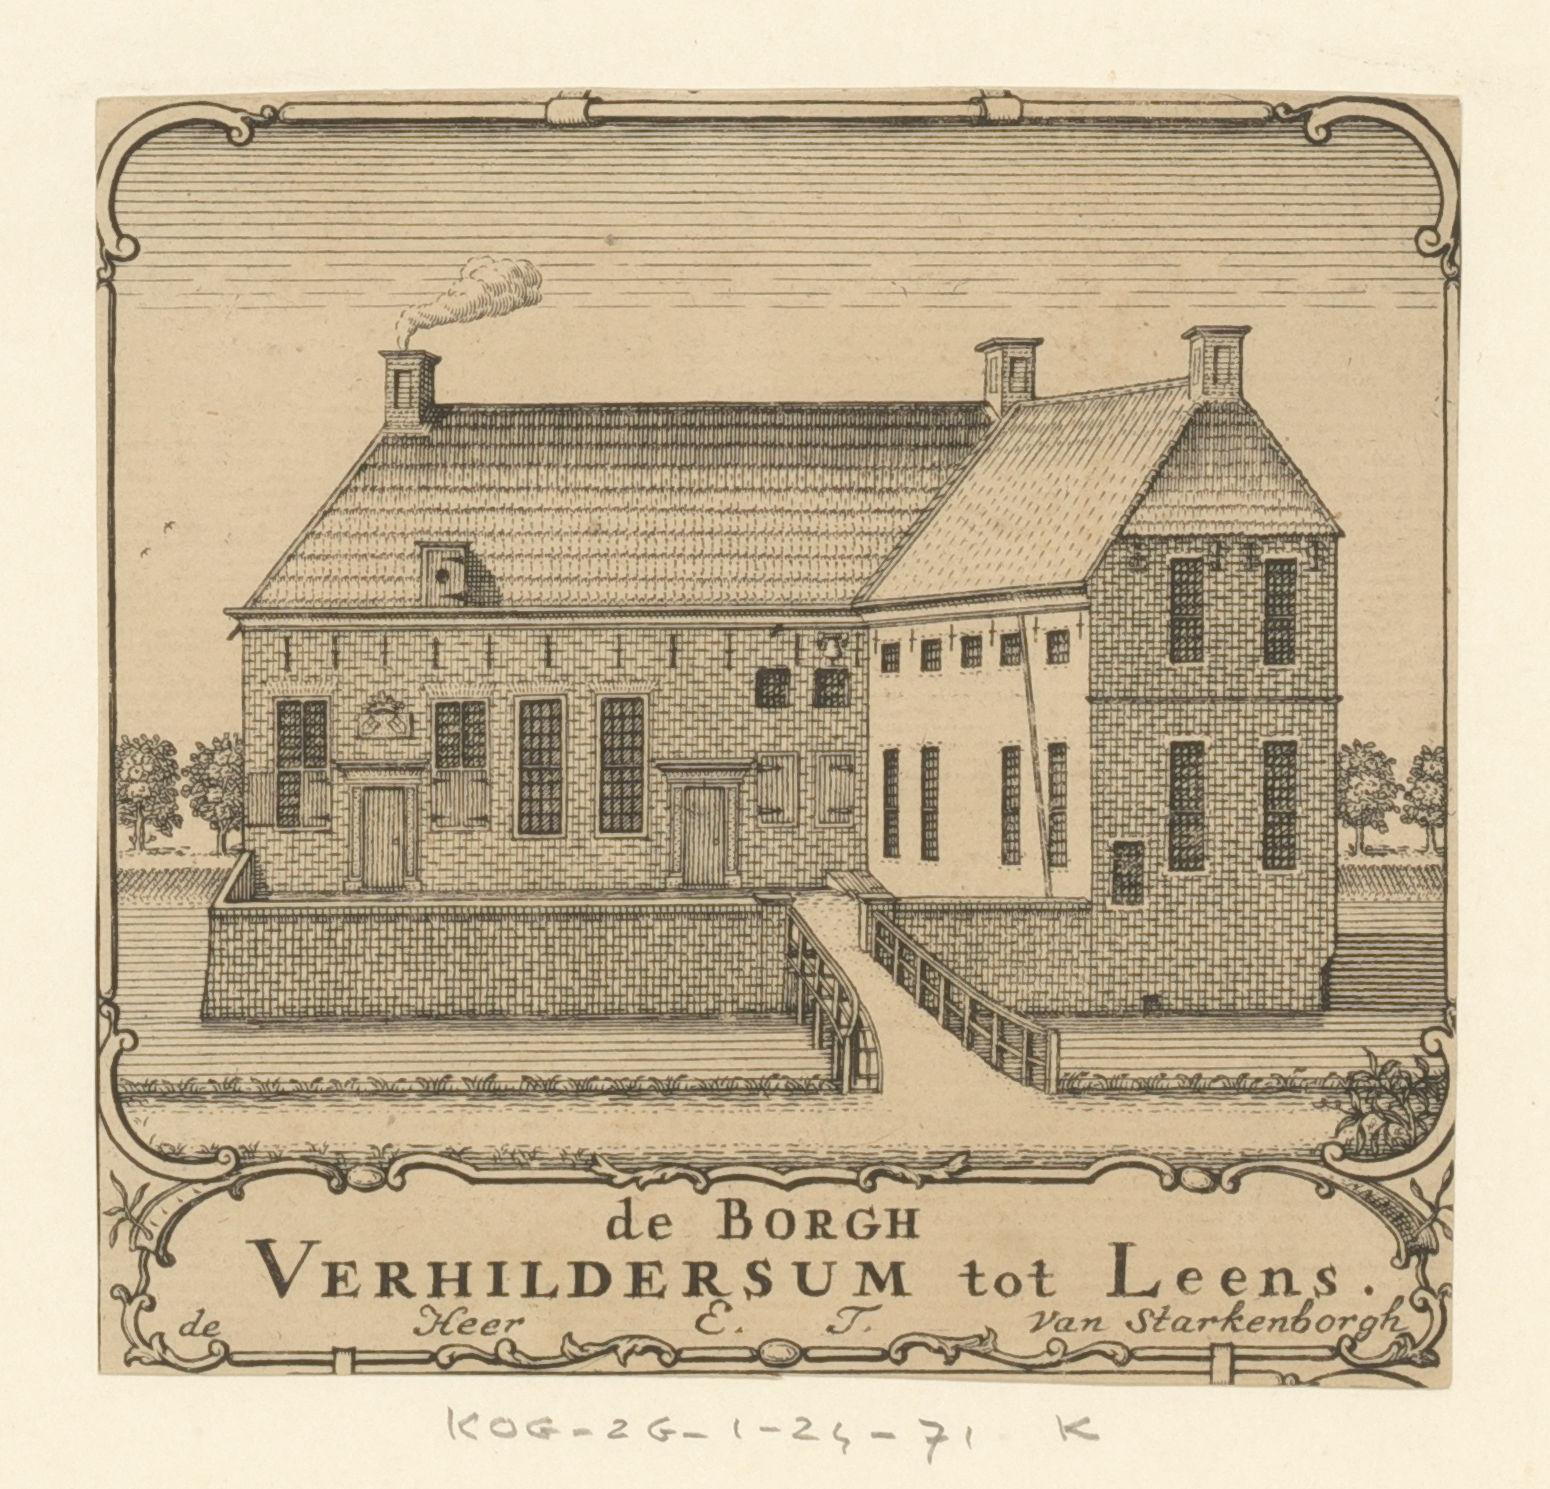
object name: print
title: De Borgh Verhildersum tot Leens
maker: theodorus beckeringh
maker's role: advocaat, cartograaf, rechter, regent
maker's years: 1712-1790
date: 1784-1849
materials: paper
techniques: engraving, etching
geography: groningen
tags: castle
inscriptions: collector's mark: Lugt 1641, stamp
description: Prent geknipt uit een grotere kaart met de titel: Nova Totius Provinciae Groningo-Omlandiae Tabula. Platen gesneden in 1777, voor het eerst uitgegeven 1784. Later ook uitgegeven in 1849.